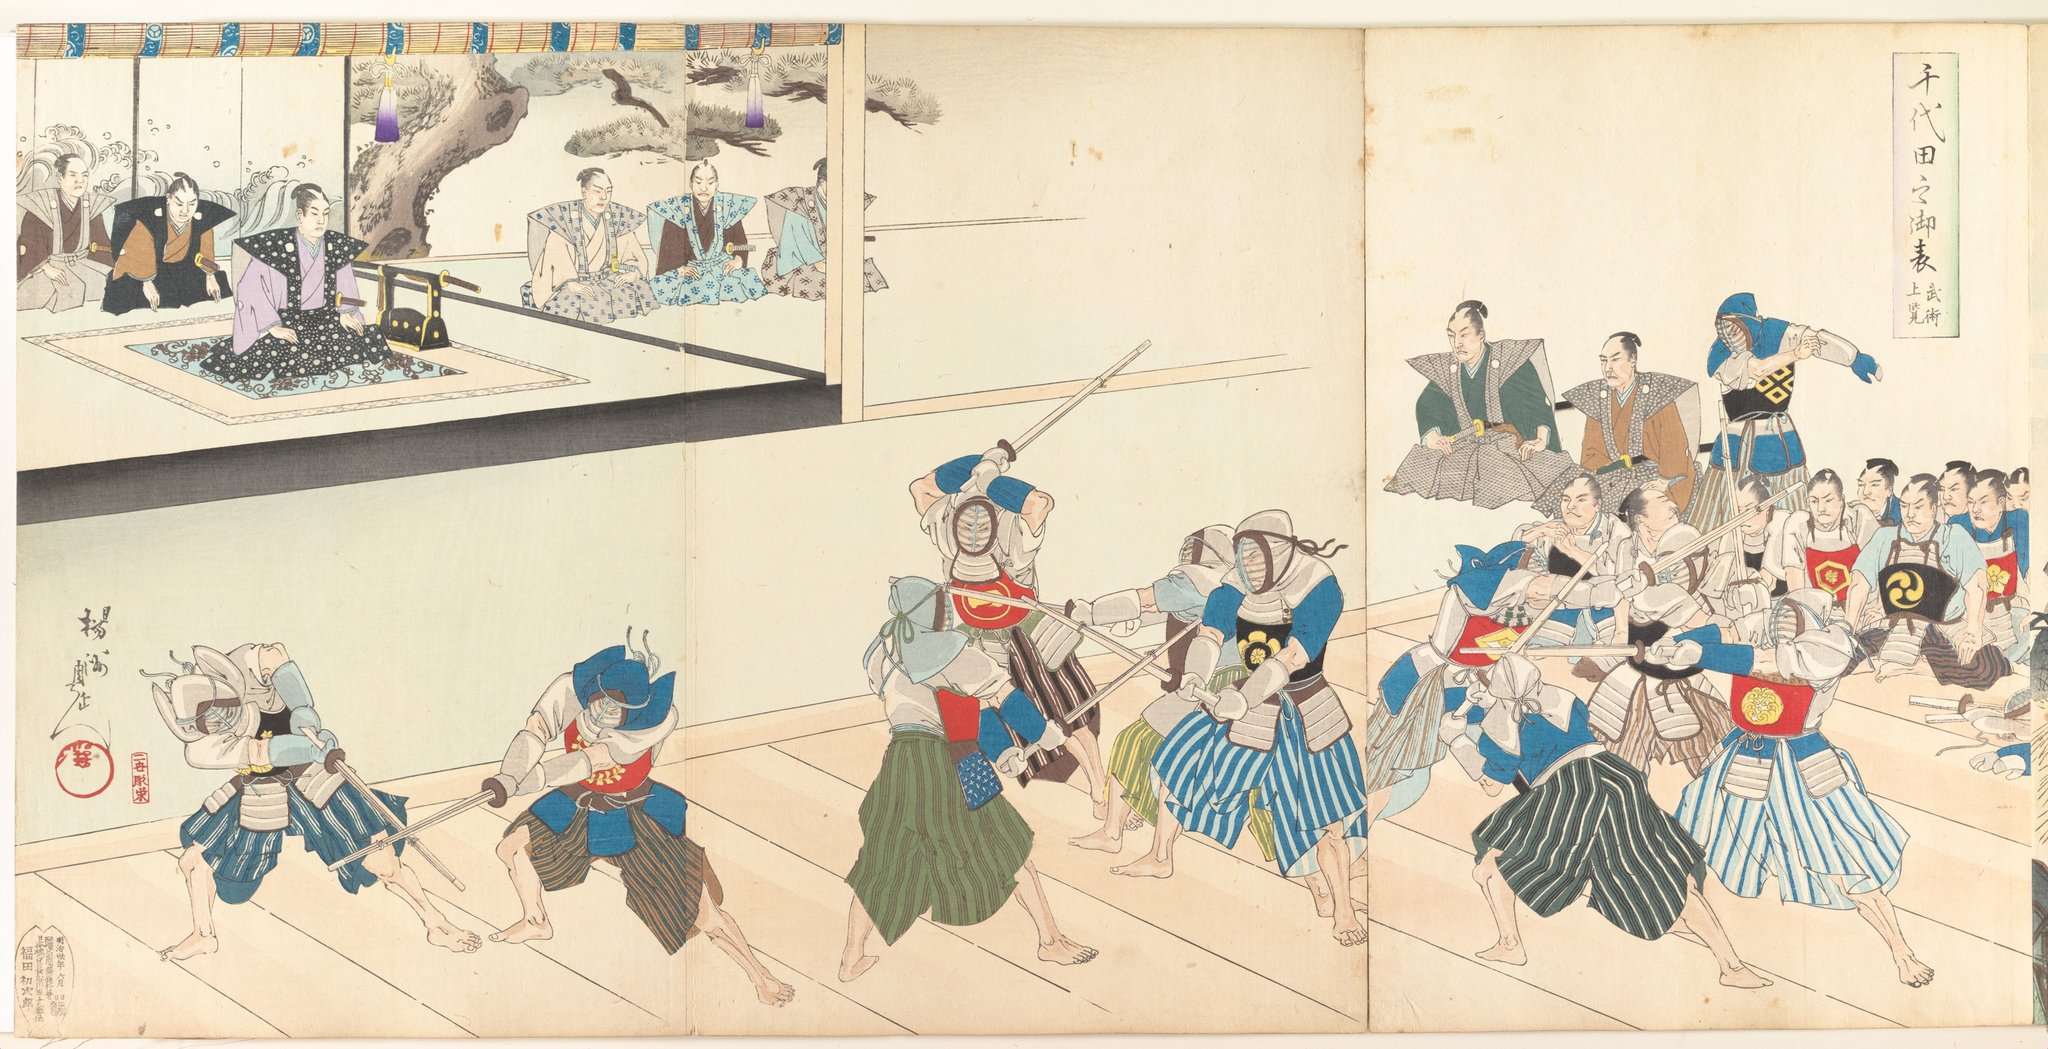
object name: print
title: Chiyoda Castle (Album of Men)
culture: japanese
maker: yōshū (hashimoto) chikanobu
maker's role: artist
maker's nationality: japanese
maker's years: 1838-1912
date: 1897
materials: ink, paper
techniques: woodblock print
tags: weapons,men,sports